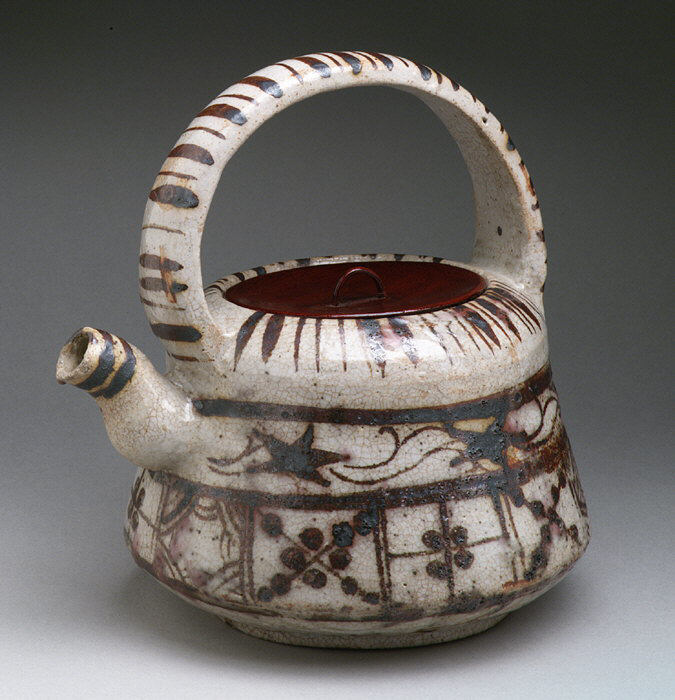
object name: ewer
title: Ewer with Floral and Striped Design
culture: japanese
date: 1601-1633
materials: iron, stoneware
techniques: underglaze